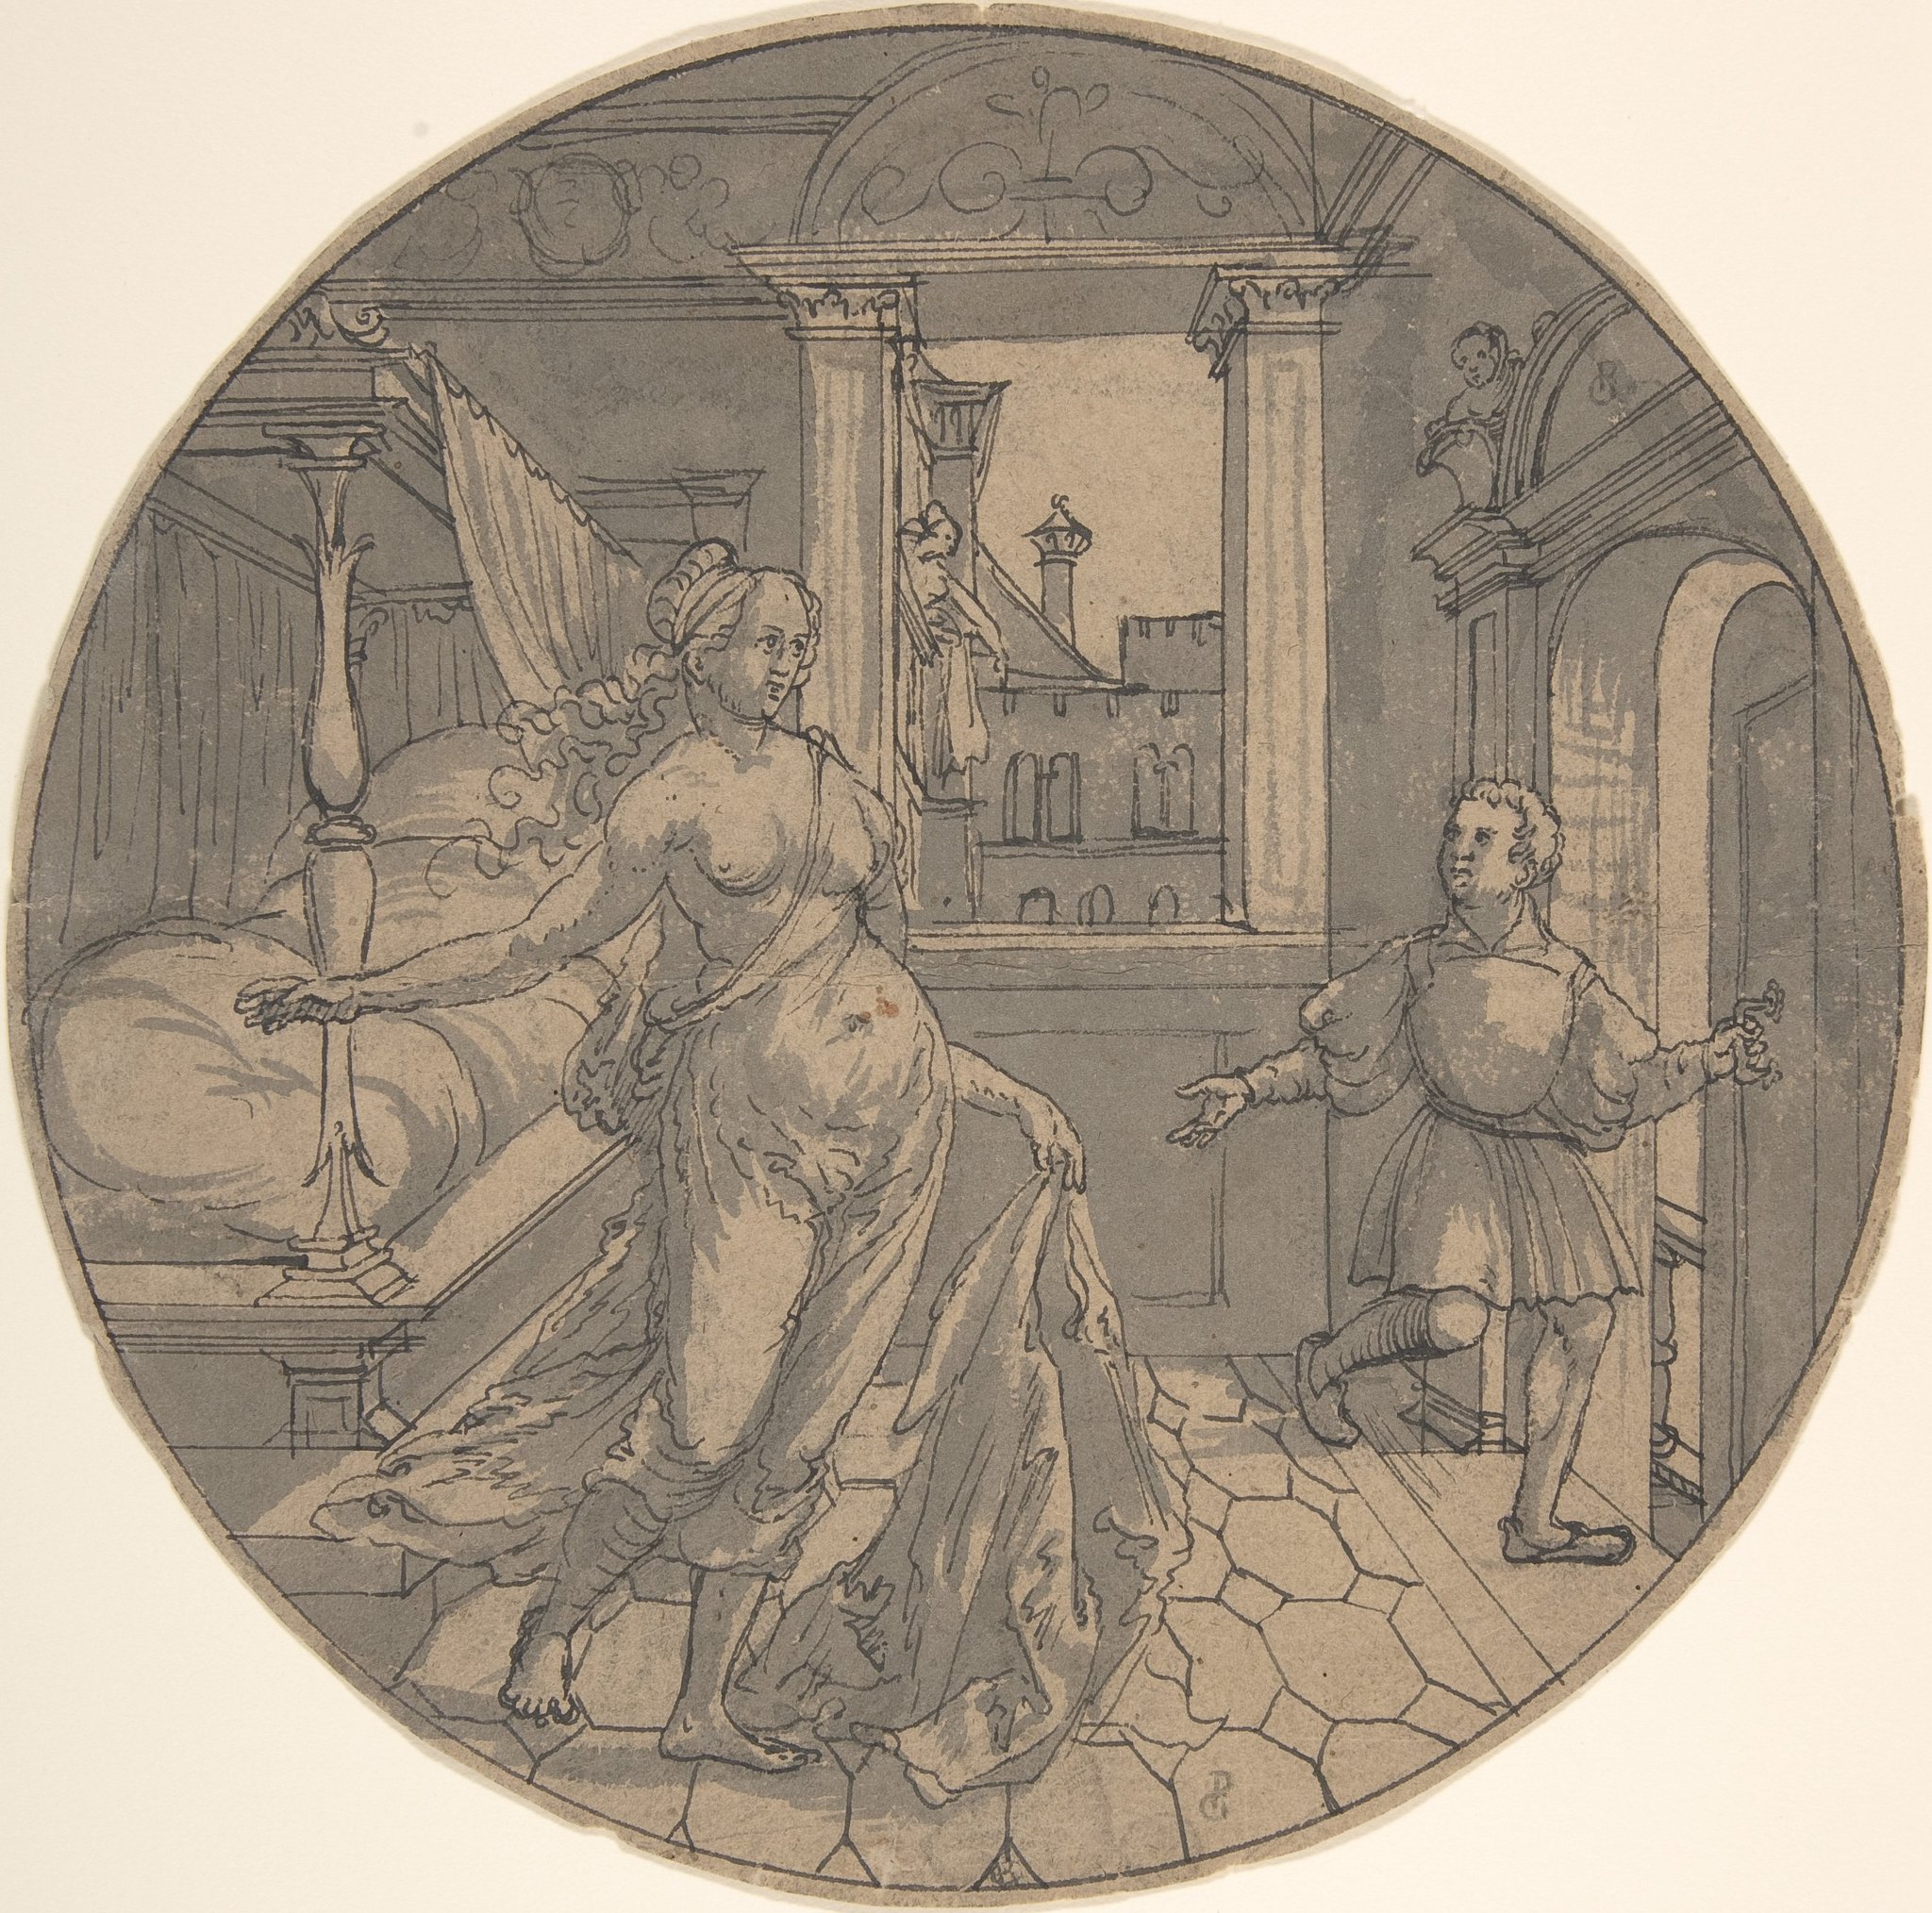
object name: drawing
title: Joseph and Potiphar's Wife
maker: georg pencz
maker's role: artist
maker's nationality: german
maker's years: 1500-1550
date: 1510-1550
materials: ink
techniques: brush, pen, wash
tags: interiors,men,women